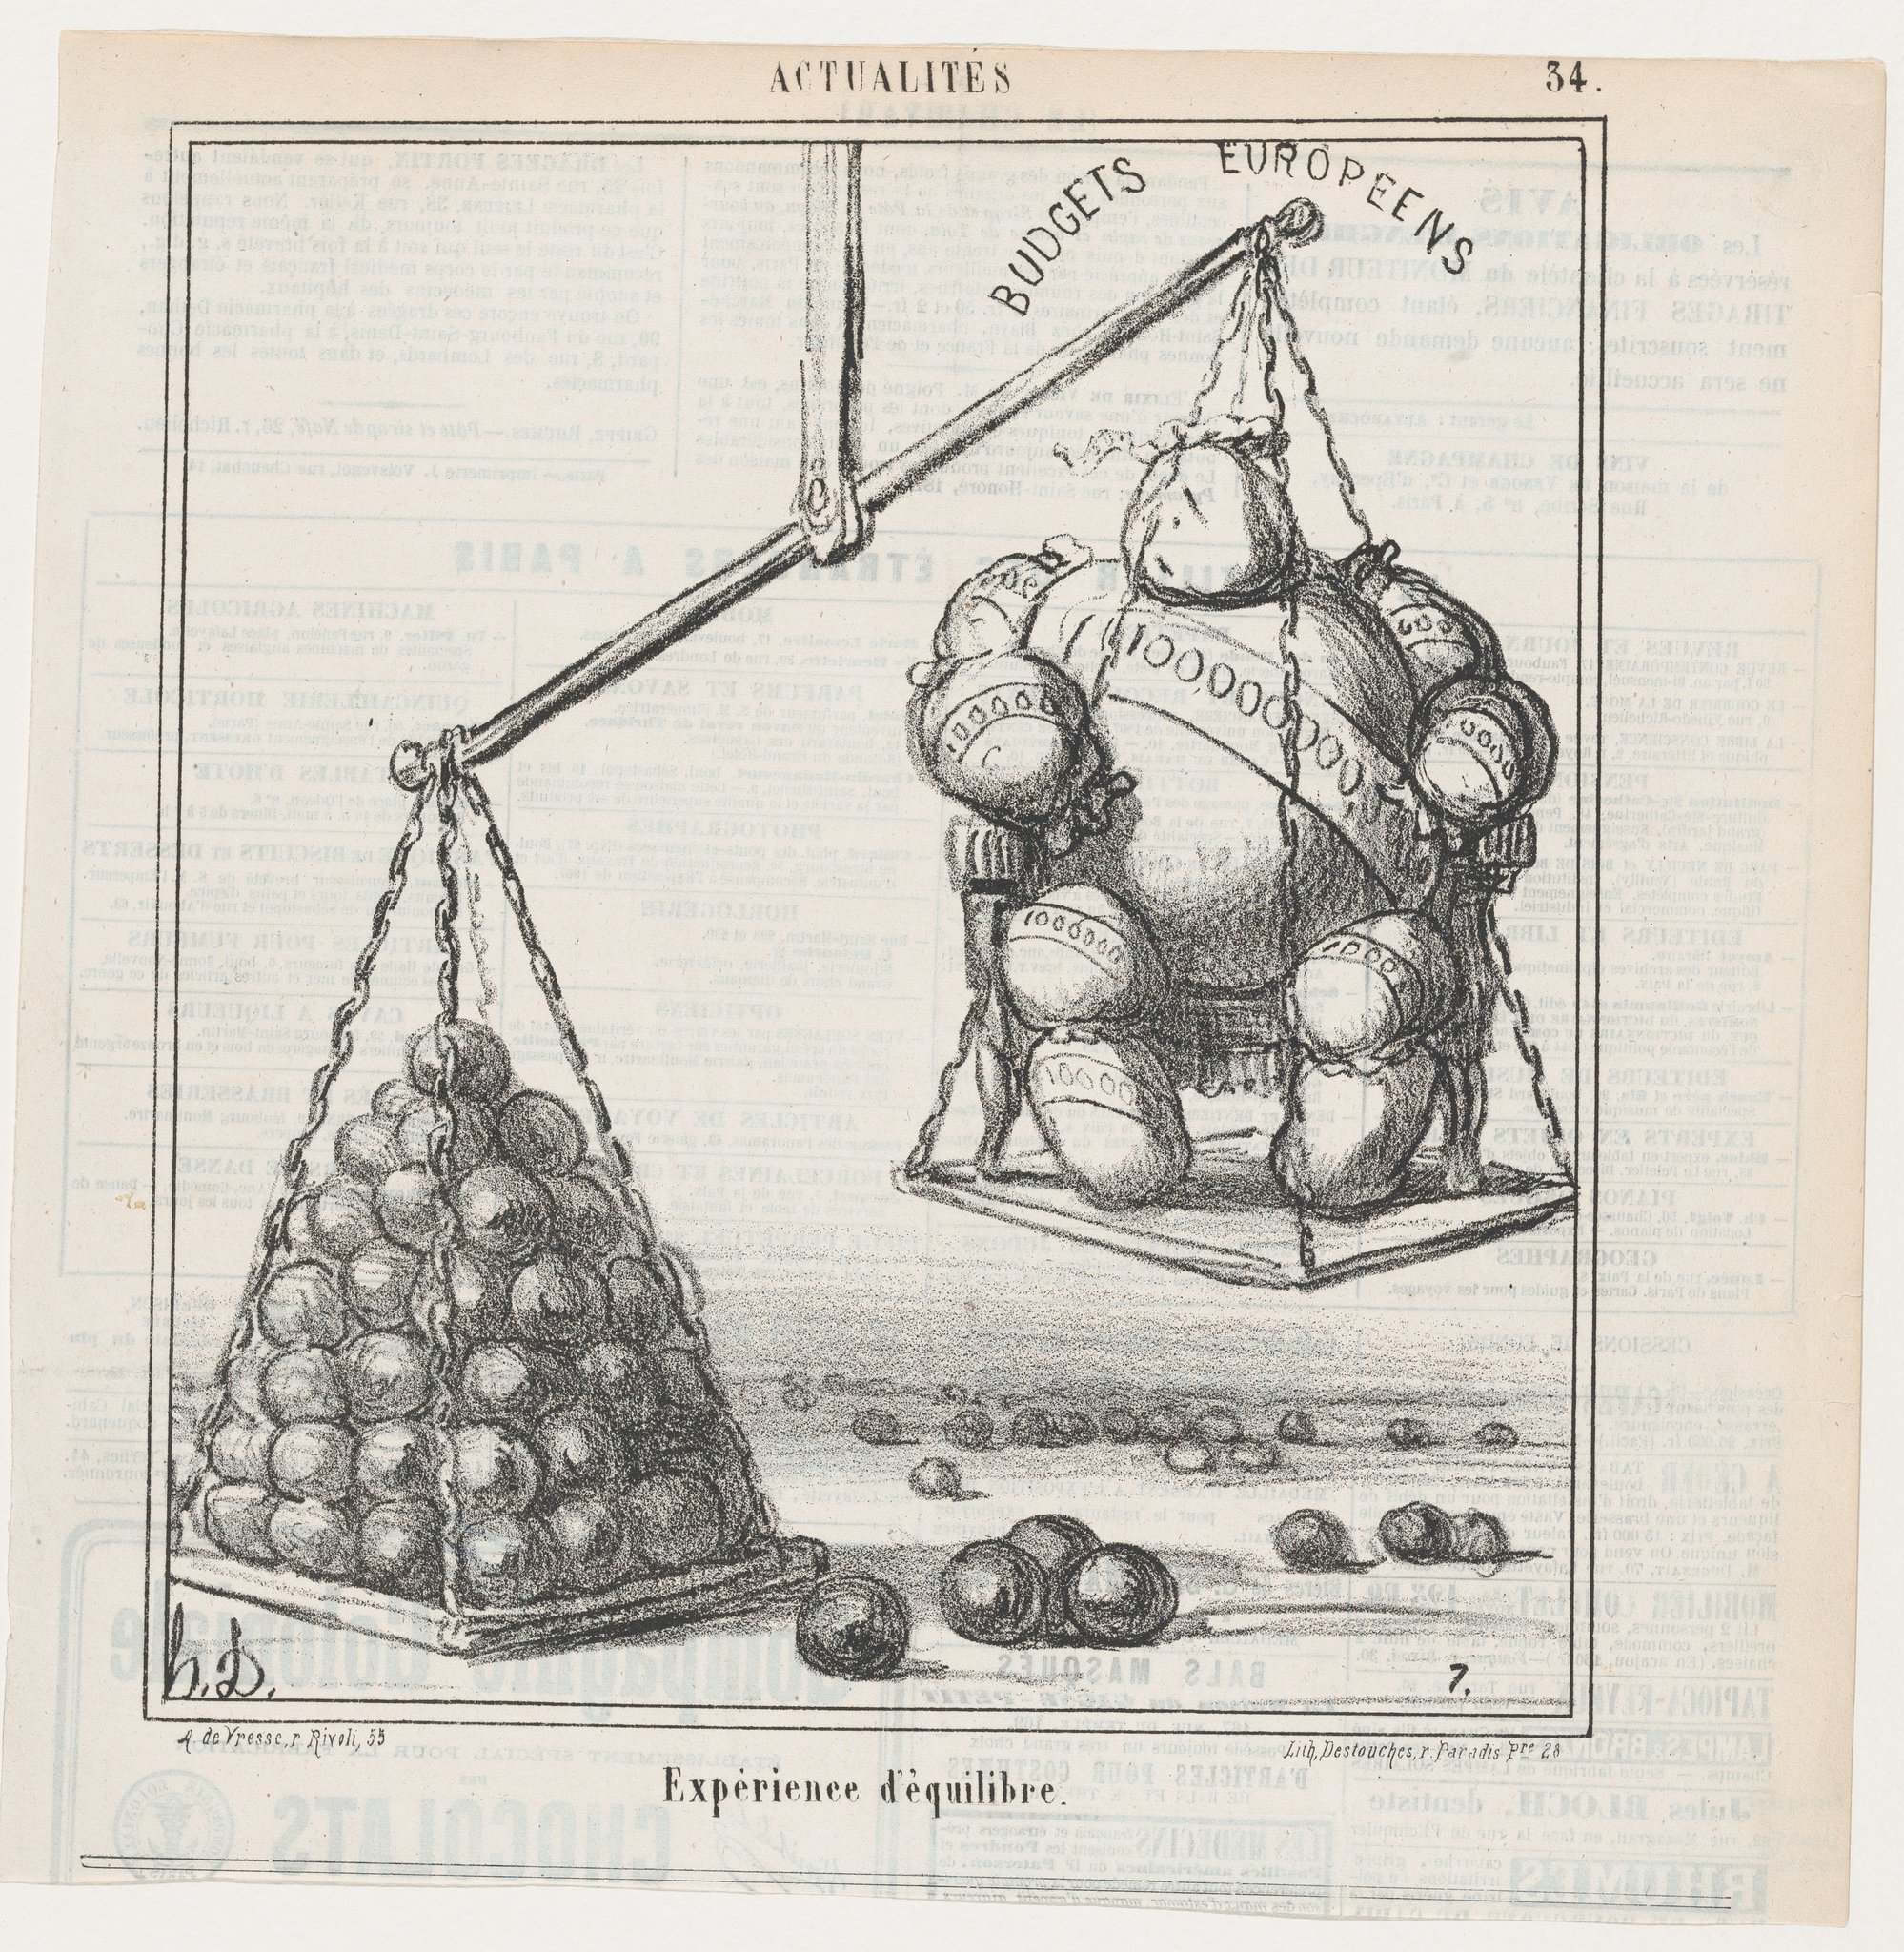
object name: print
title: An experience with equilibrium, from 'News of the day,' published in "Le Charivari"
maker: honoré daumier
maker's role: artist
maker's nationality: french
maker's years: 1808-1879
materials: paper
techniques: lithograph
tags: satire,scales